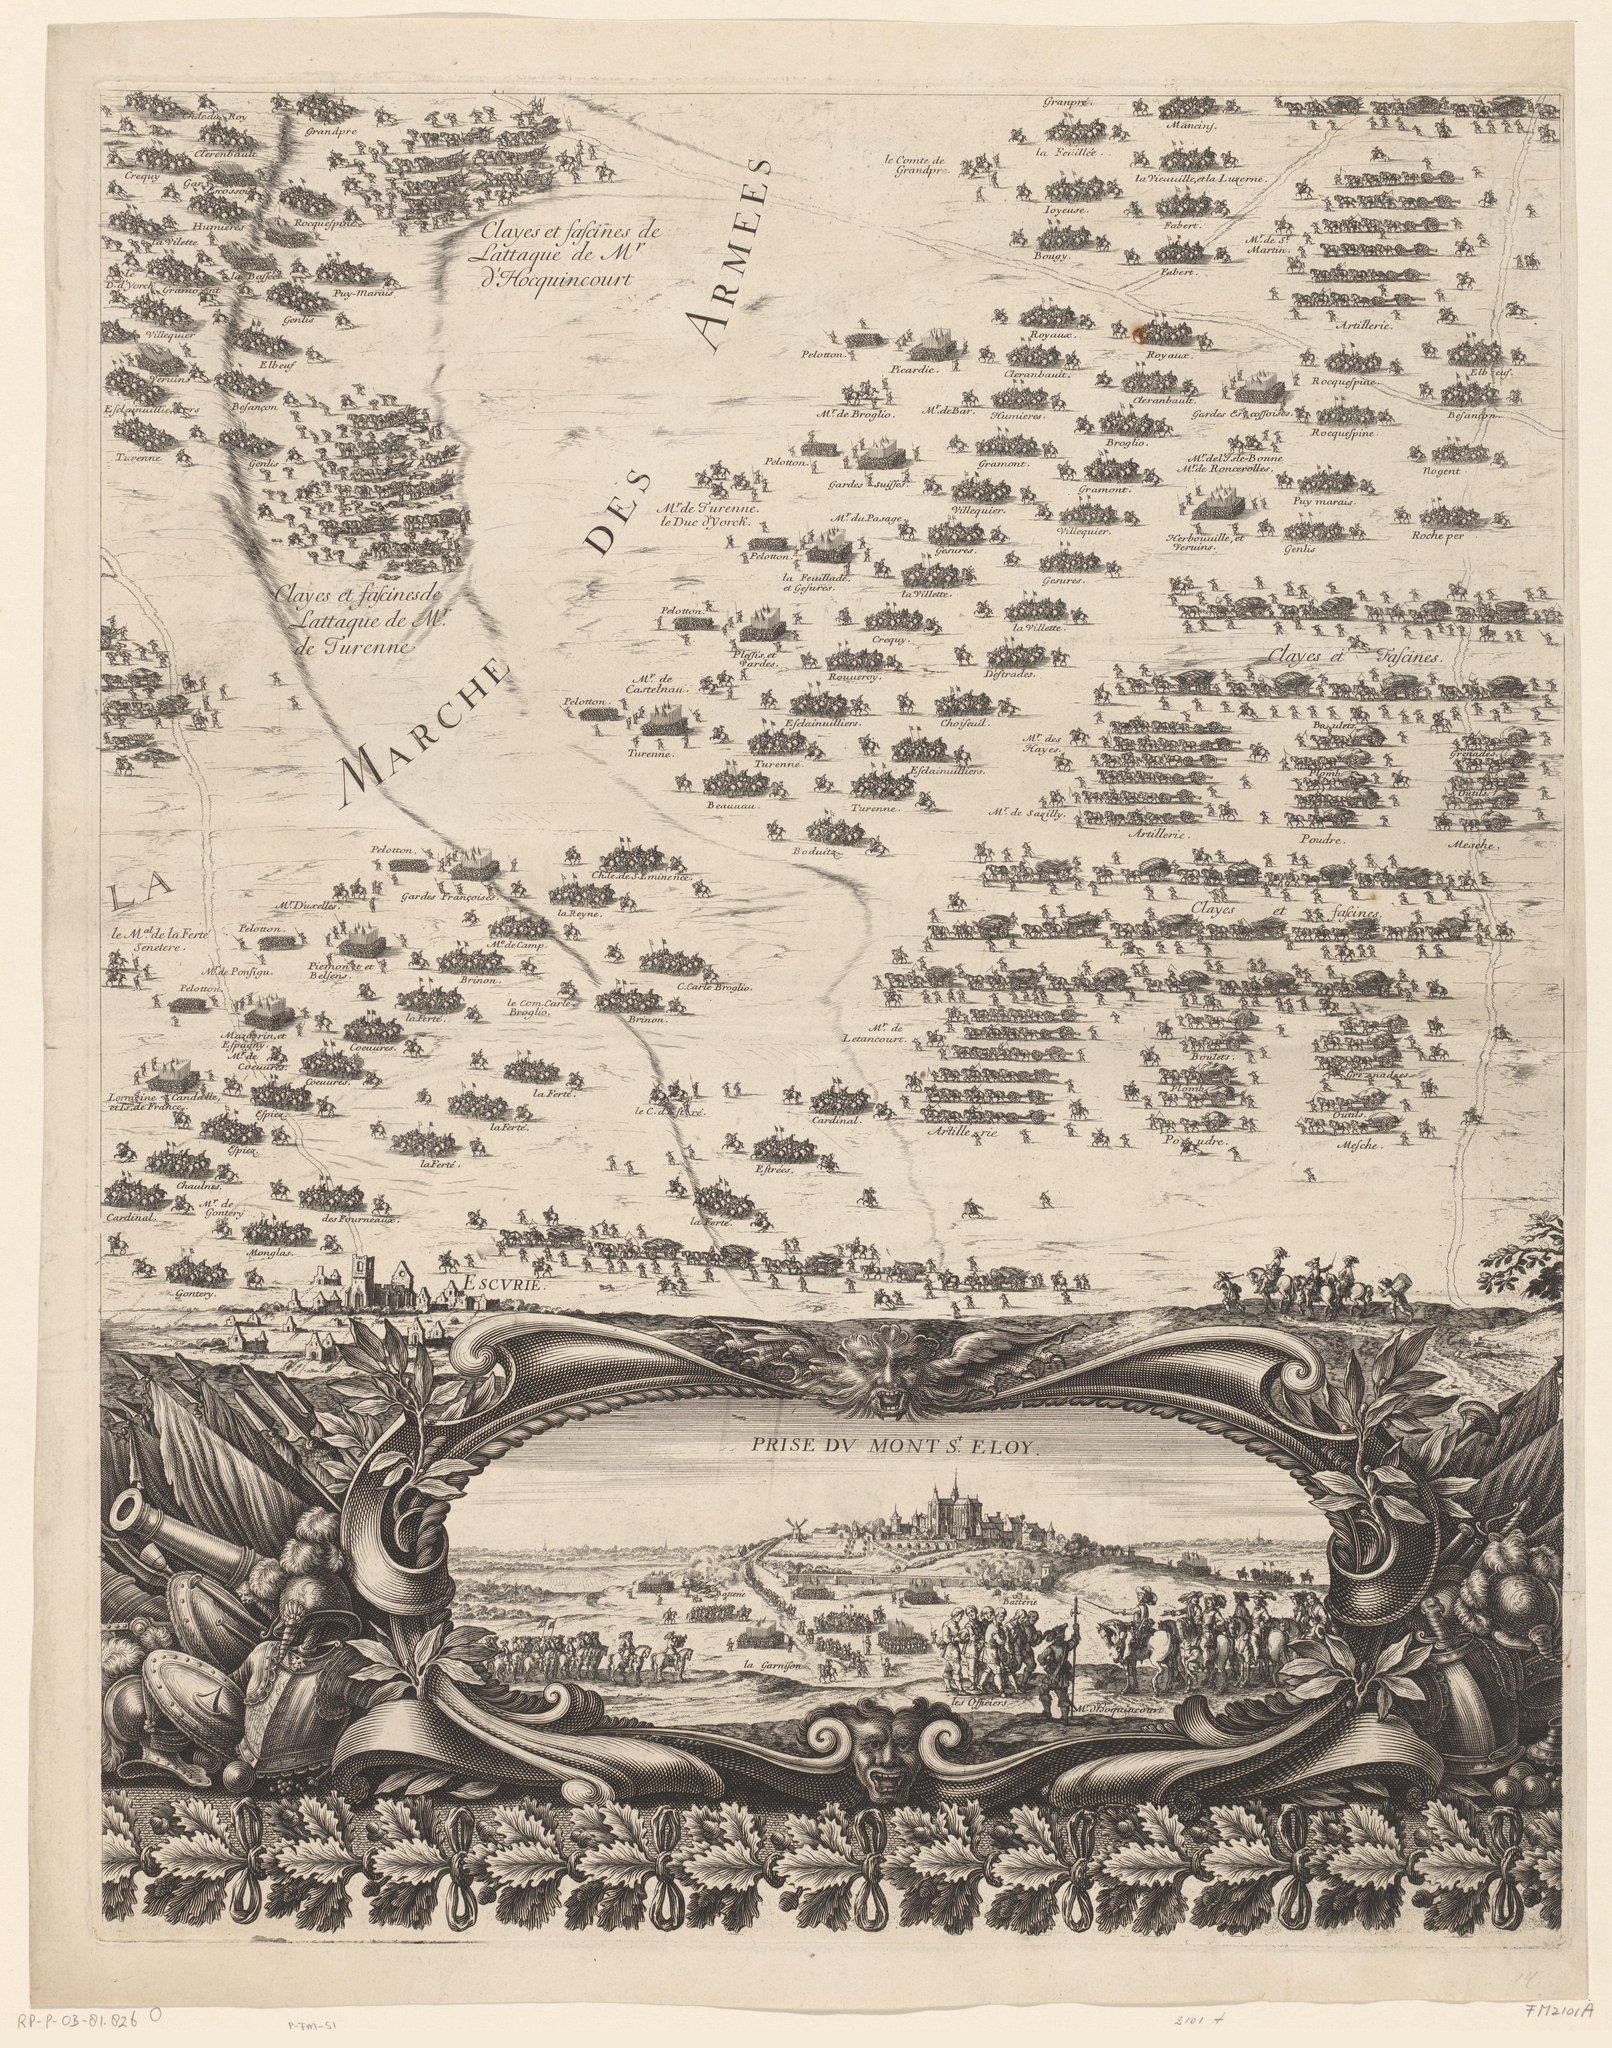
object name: print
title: Ontzet van Arras, belegerd door de Spanjaarden (onderste rij, plaat 4), 1654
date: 1655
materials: paper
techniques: engraving, etching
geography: france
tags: vienna, leopold willem van oostenrijk (landvoogd der zuidelijke nederlanden), raising the siege with outside assistance, relief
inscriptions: date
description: Ontzet van de stad Arras (Atrecht), belegerd door de Spanjaarden, 23-25 augustus 1654. Arras ontzet door het Franse leger onder de maarschalk Turenne van het beleg door de Spanjaarden onder Louis de Condé en aartshertog Leopold Willem. Vierde blad in de onderste rij. Deel van de kaart van de aanvallende Franse troepen, onderaan een cartouche met de inname van Mont St. Eloy. Onderdeel van een ongemonteerd geheel bestaande uit een titelblad en een grote voorstelling op vijftien platen (de halve plaat rechtsonder ontbreekt).